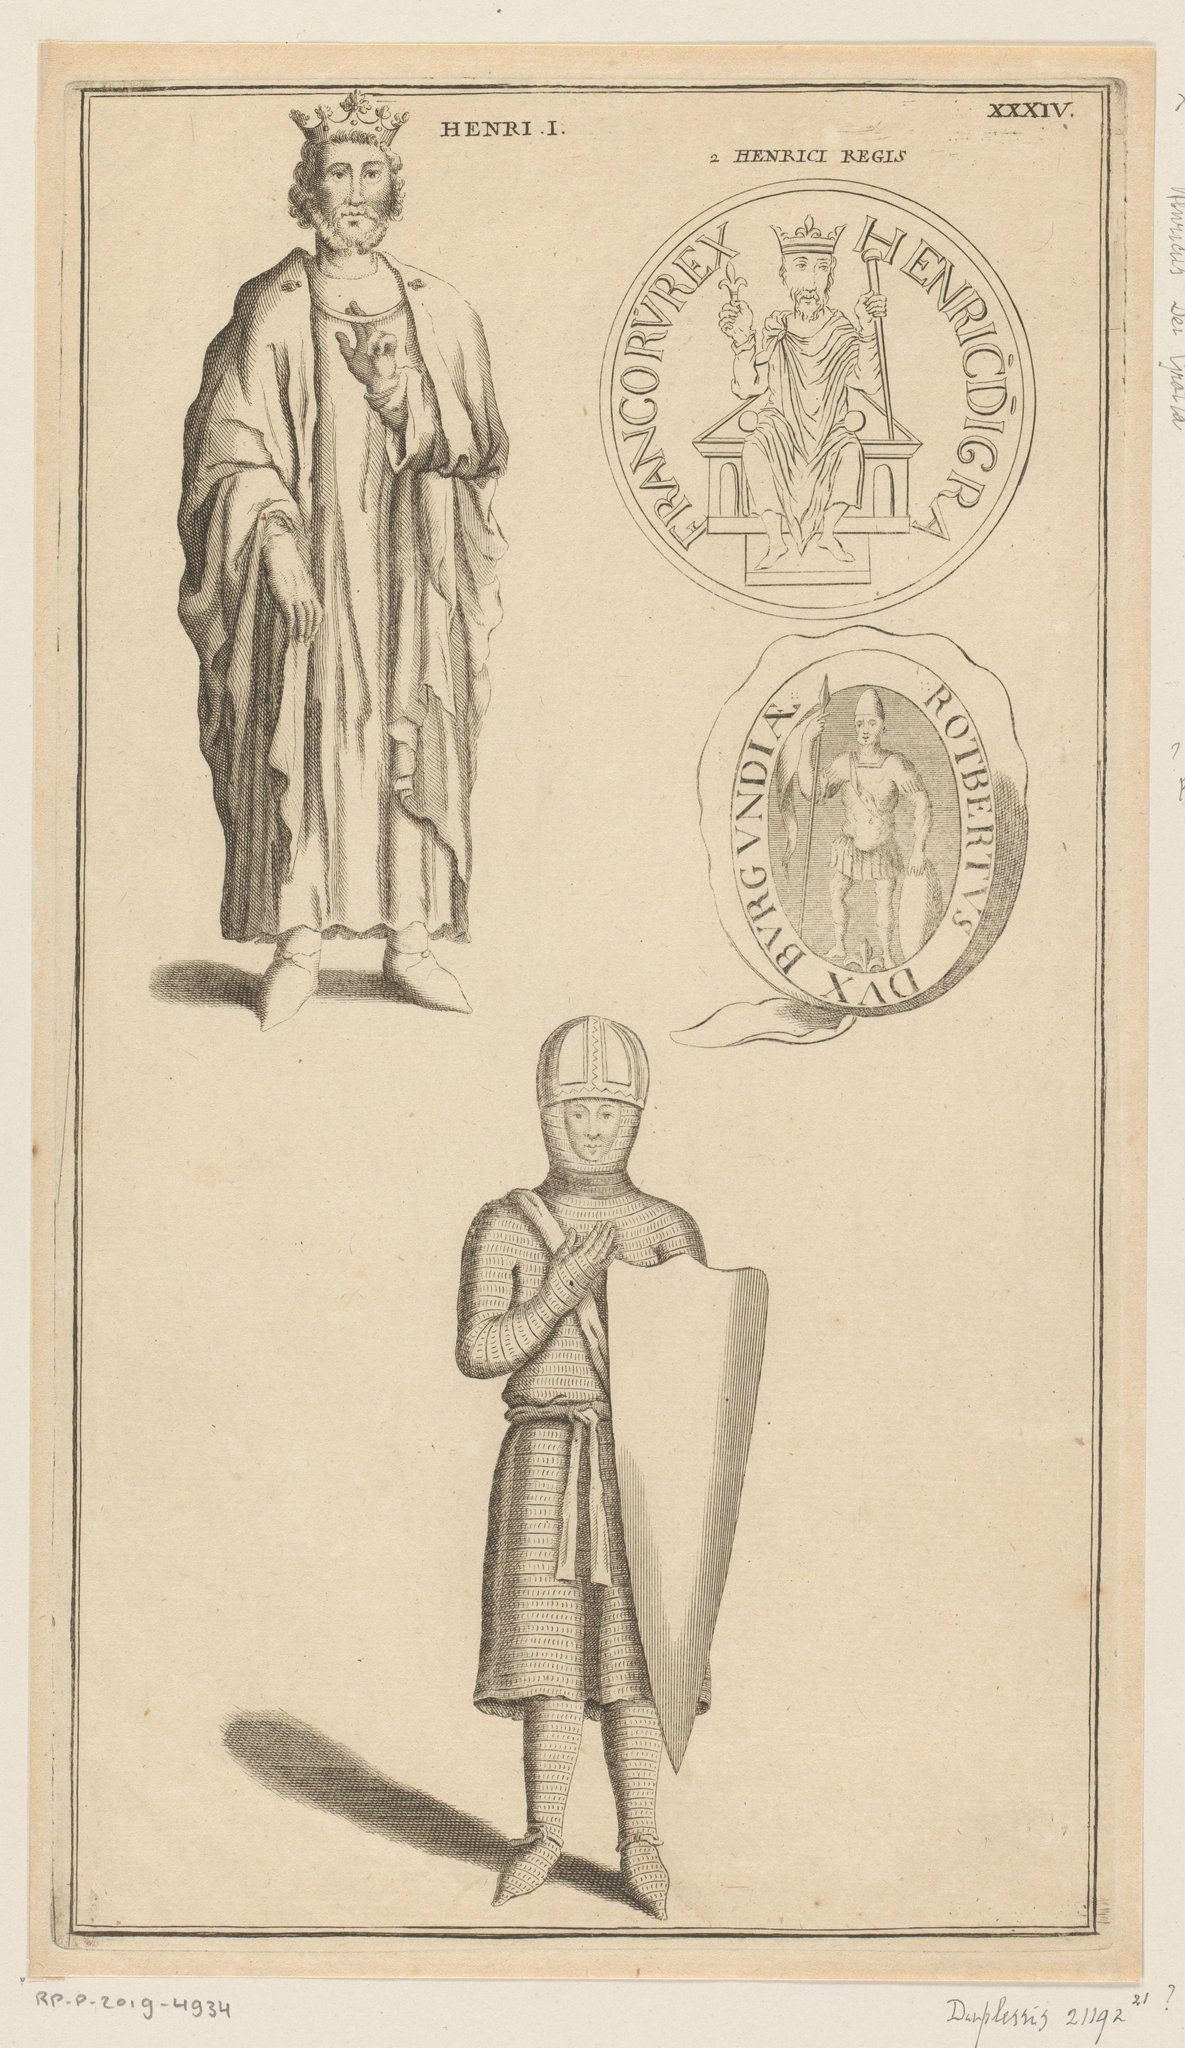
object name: print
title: Afbeeldingen van koning Robert II en Hendrik I van Frankrijk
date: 1750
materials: paper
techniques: engraving, etching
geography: london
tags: sealing wax, historical persons, coin, king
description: Prent uit: Montfaucon, Bernard de. A collection of regal and ecclesiastical antiquities of France (...). Londen: William Innys, John en Paul Knapton, R. Manby en Henry Shute Cox, 1750, dl. 1. Prent voor het eerst, met andere nummering, verschenen in: Montfaucon, Bernard de. Les monumens de la Monarchie Françoise (...). Parijs: Julien-Michel Gandouin en Pierre-François Giffart, 1729-1733.